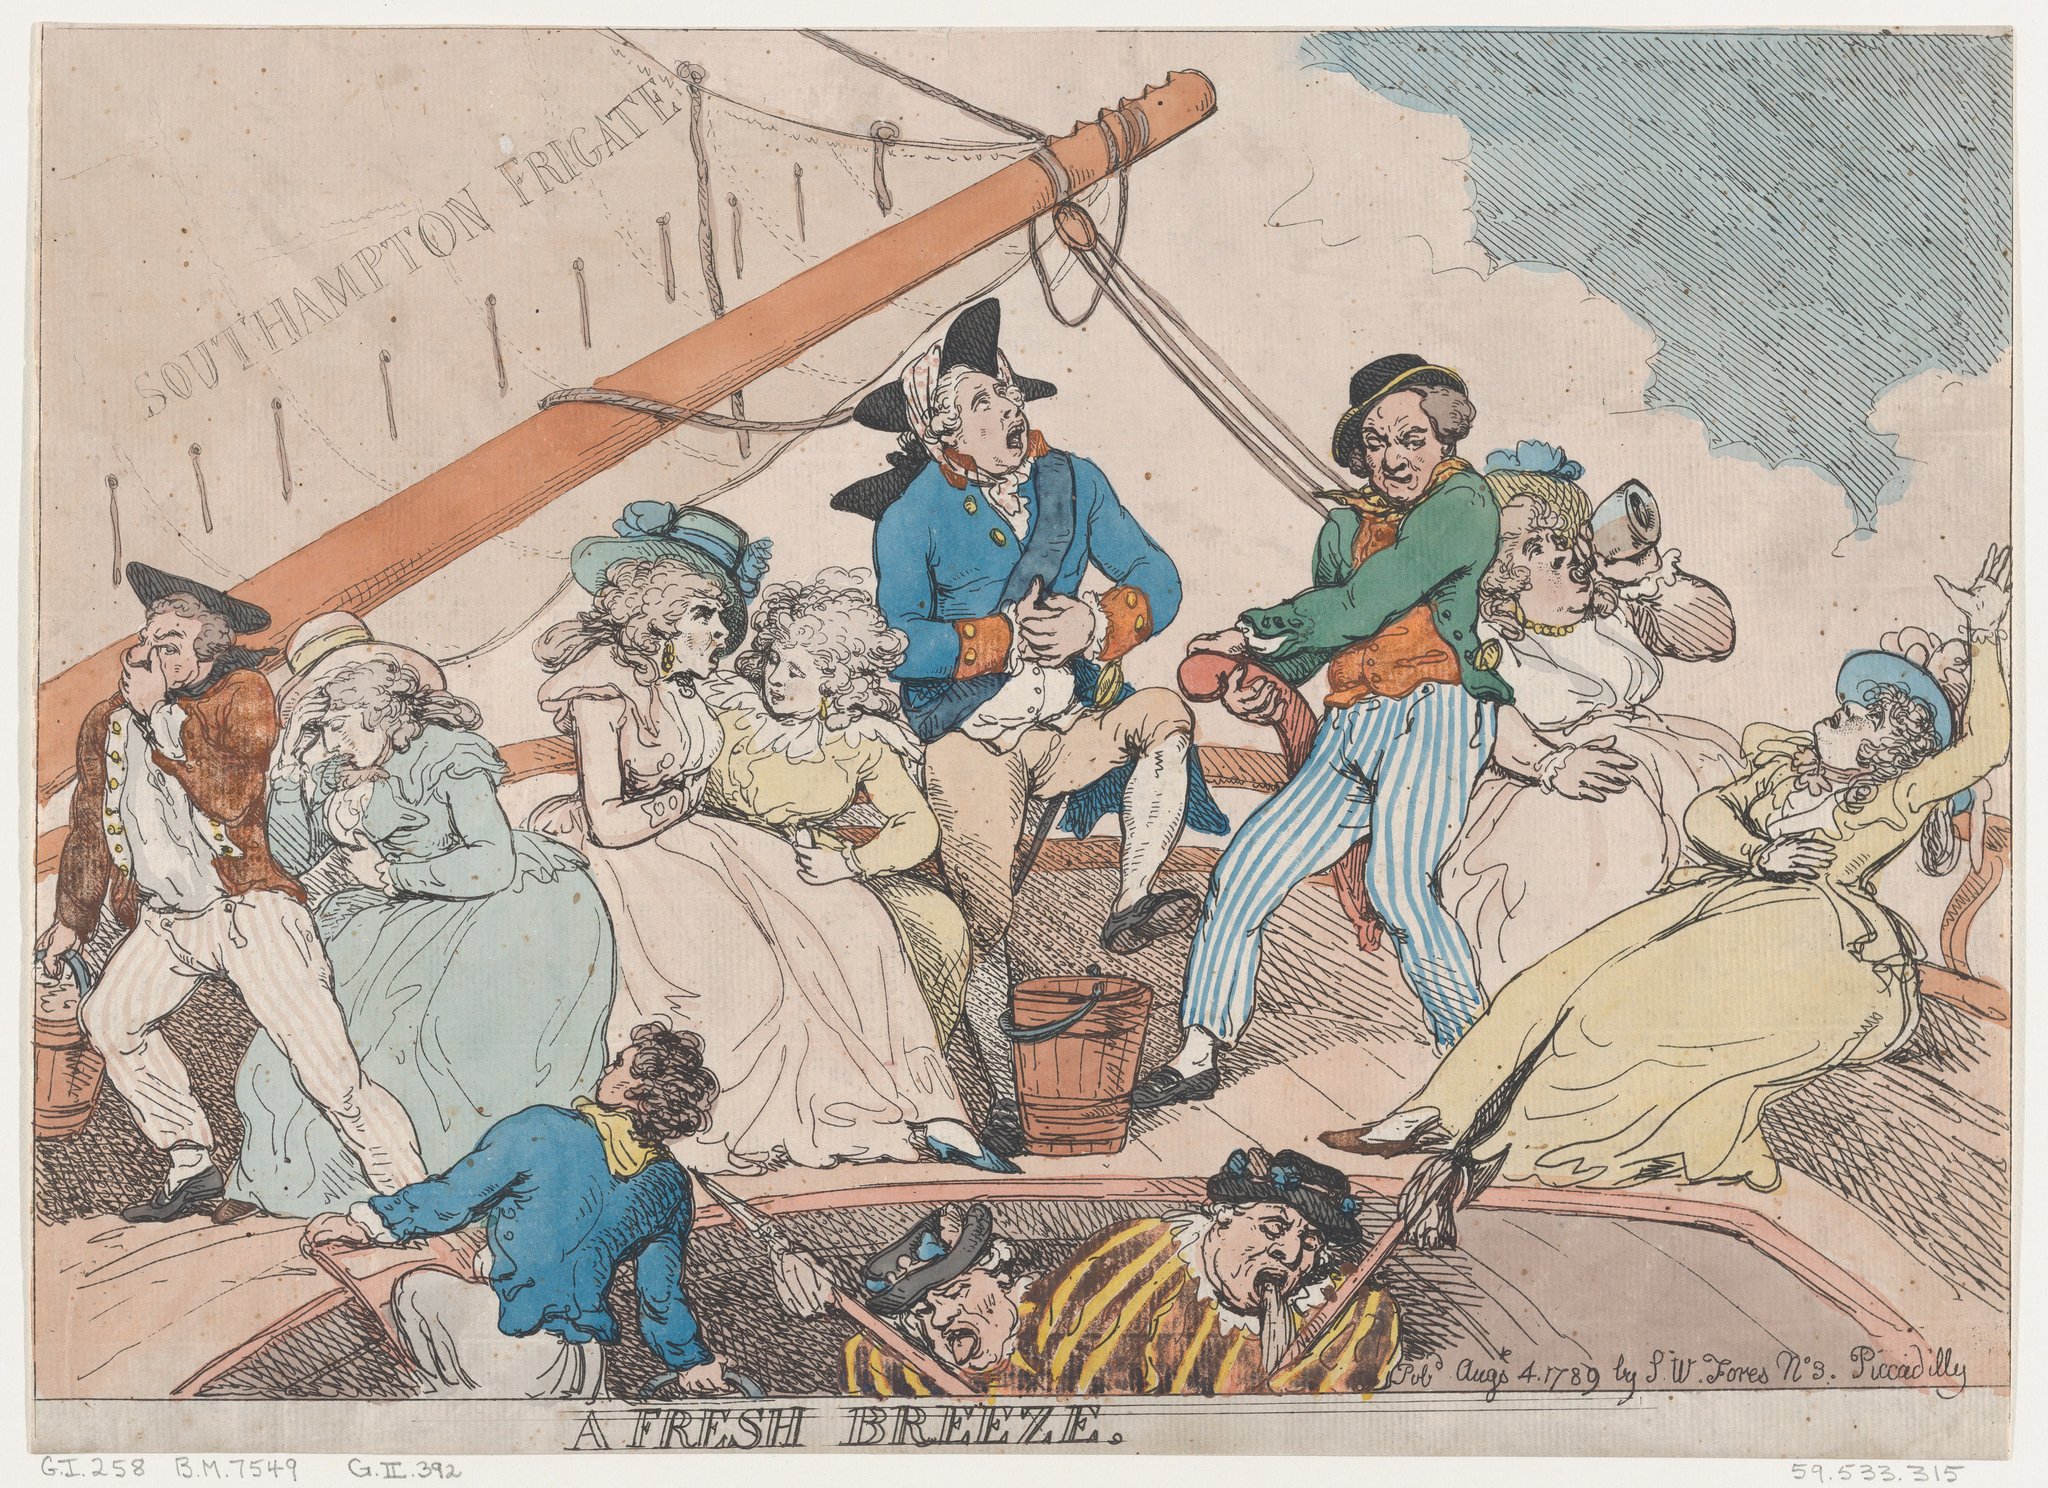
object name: print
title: A Fresh Breeze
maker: thomas rowlandson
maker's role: artist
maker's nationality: british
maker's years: 1757-1827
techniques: etching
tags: satire,illness,men,women,boats